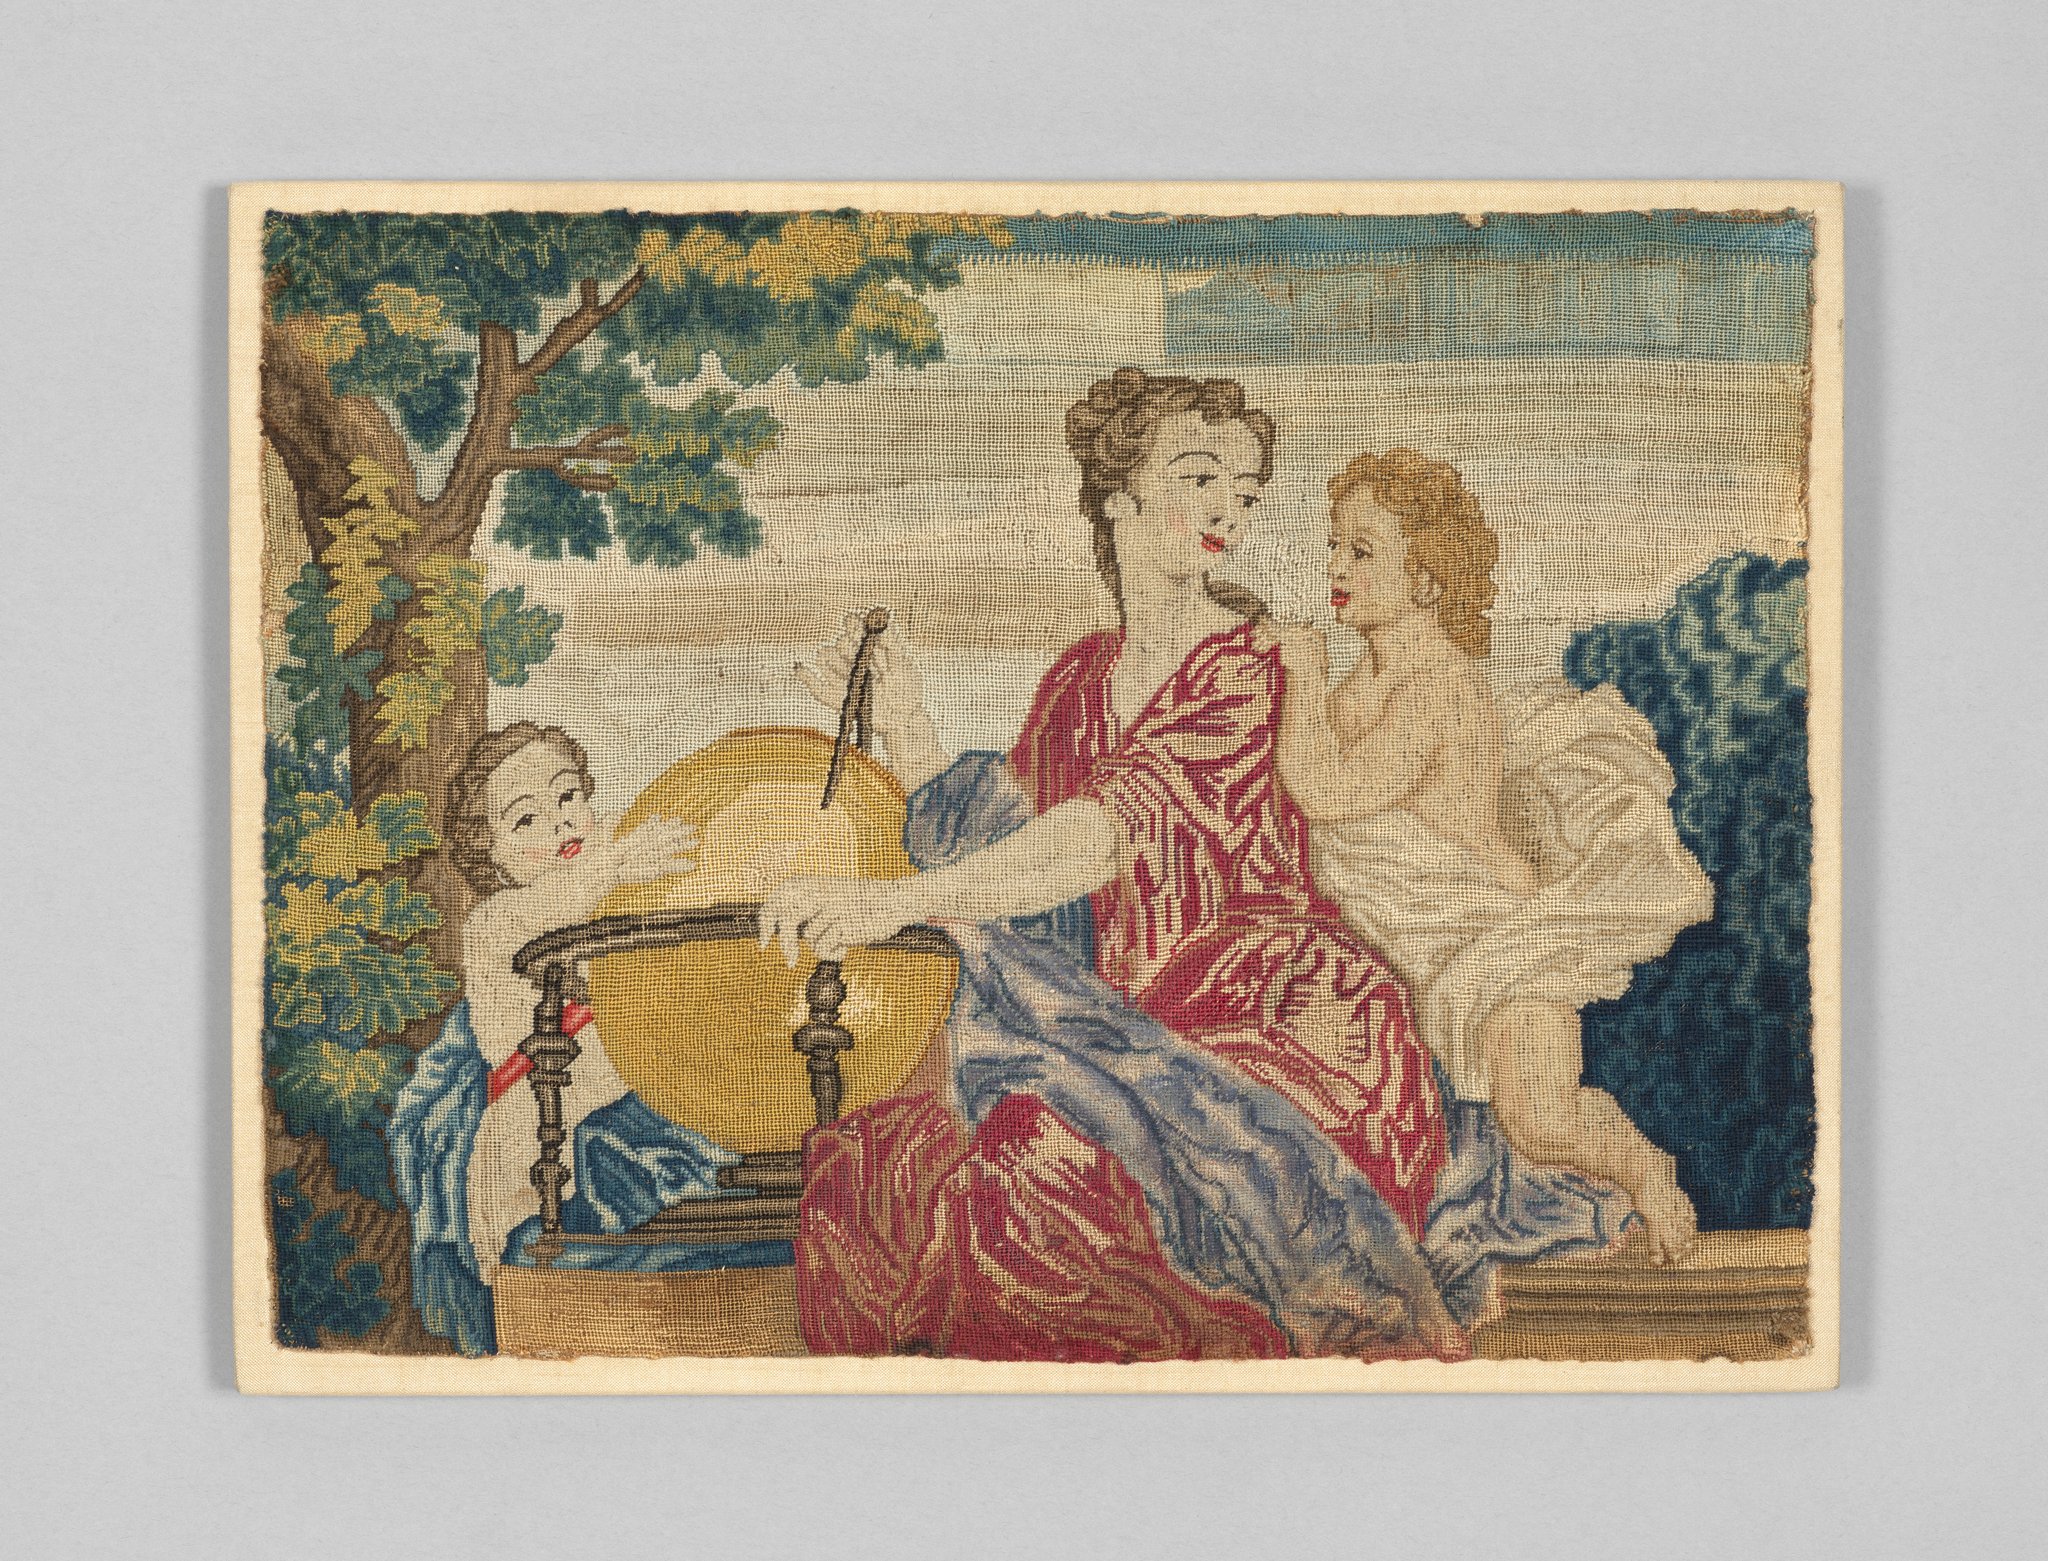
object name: embroidered picture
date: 1701-1750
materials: canvas, silk, wool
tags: women,globes